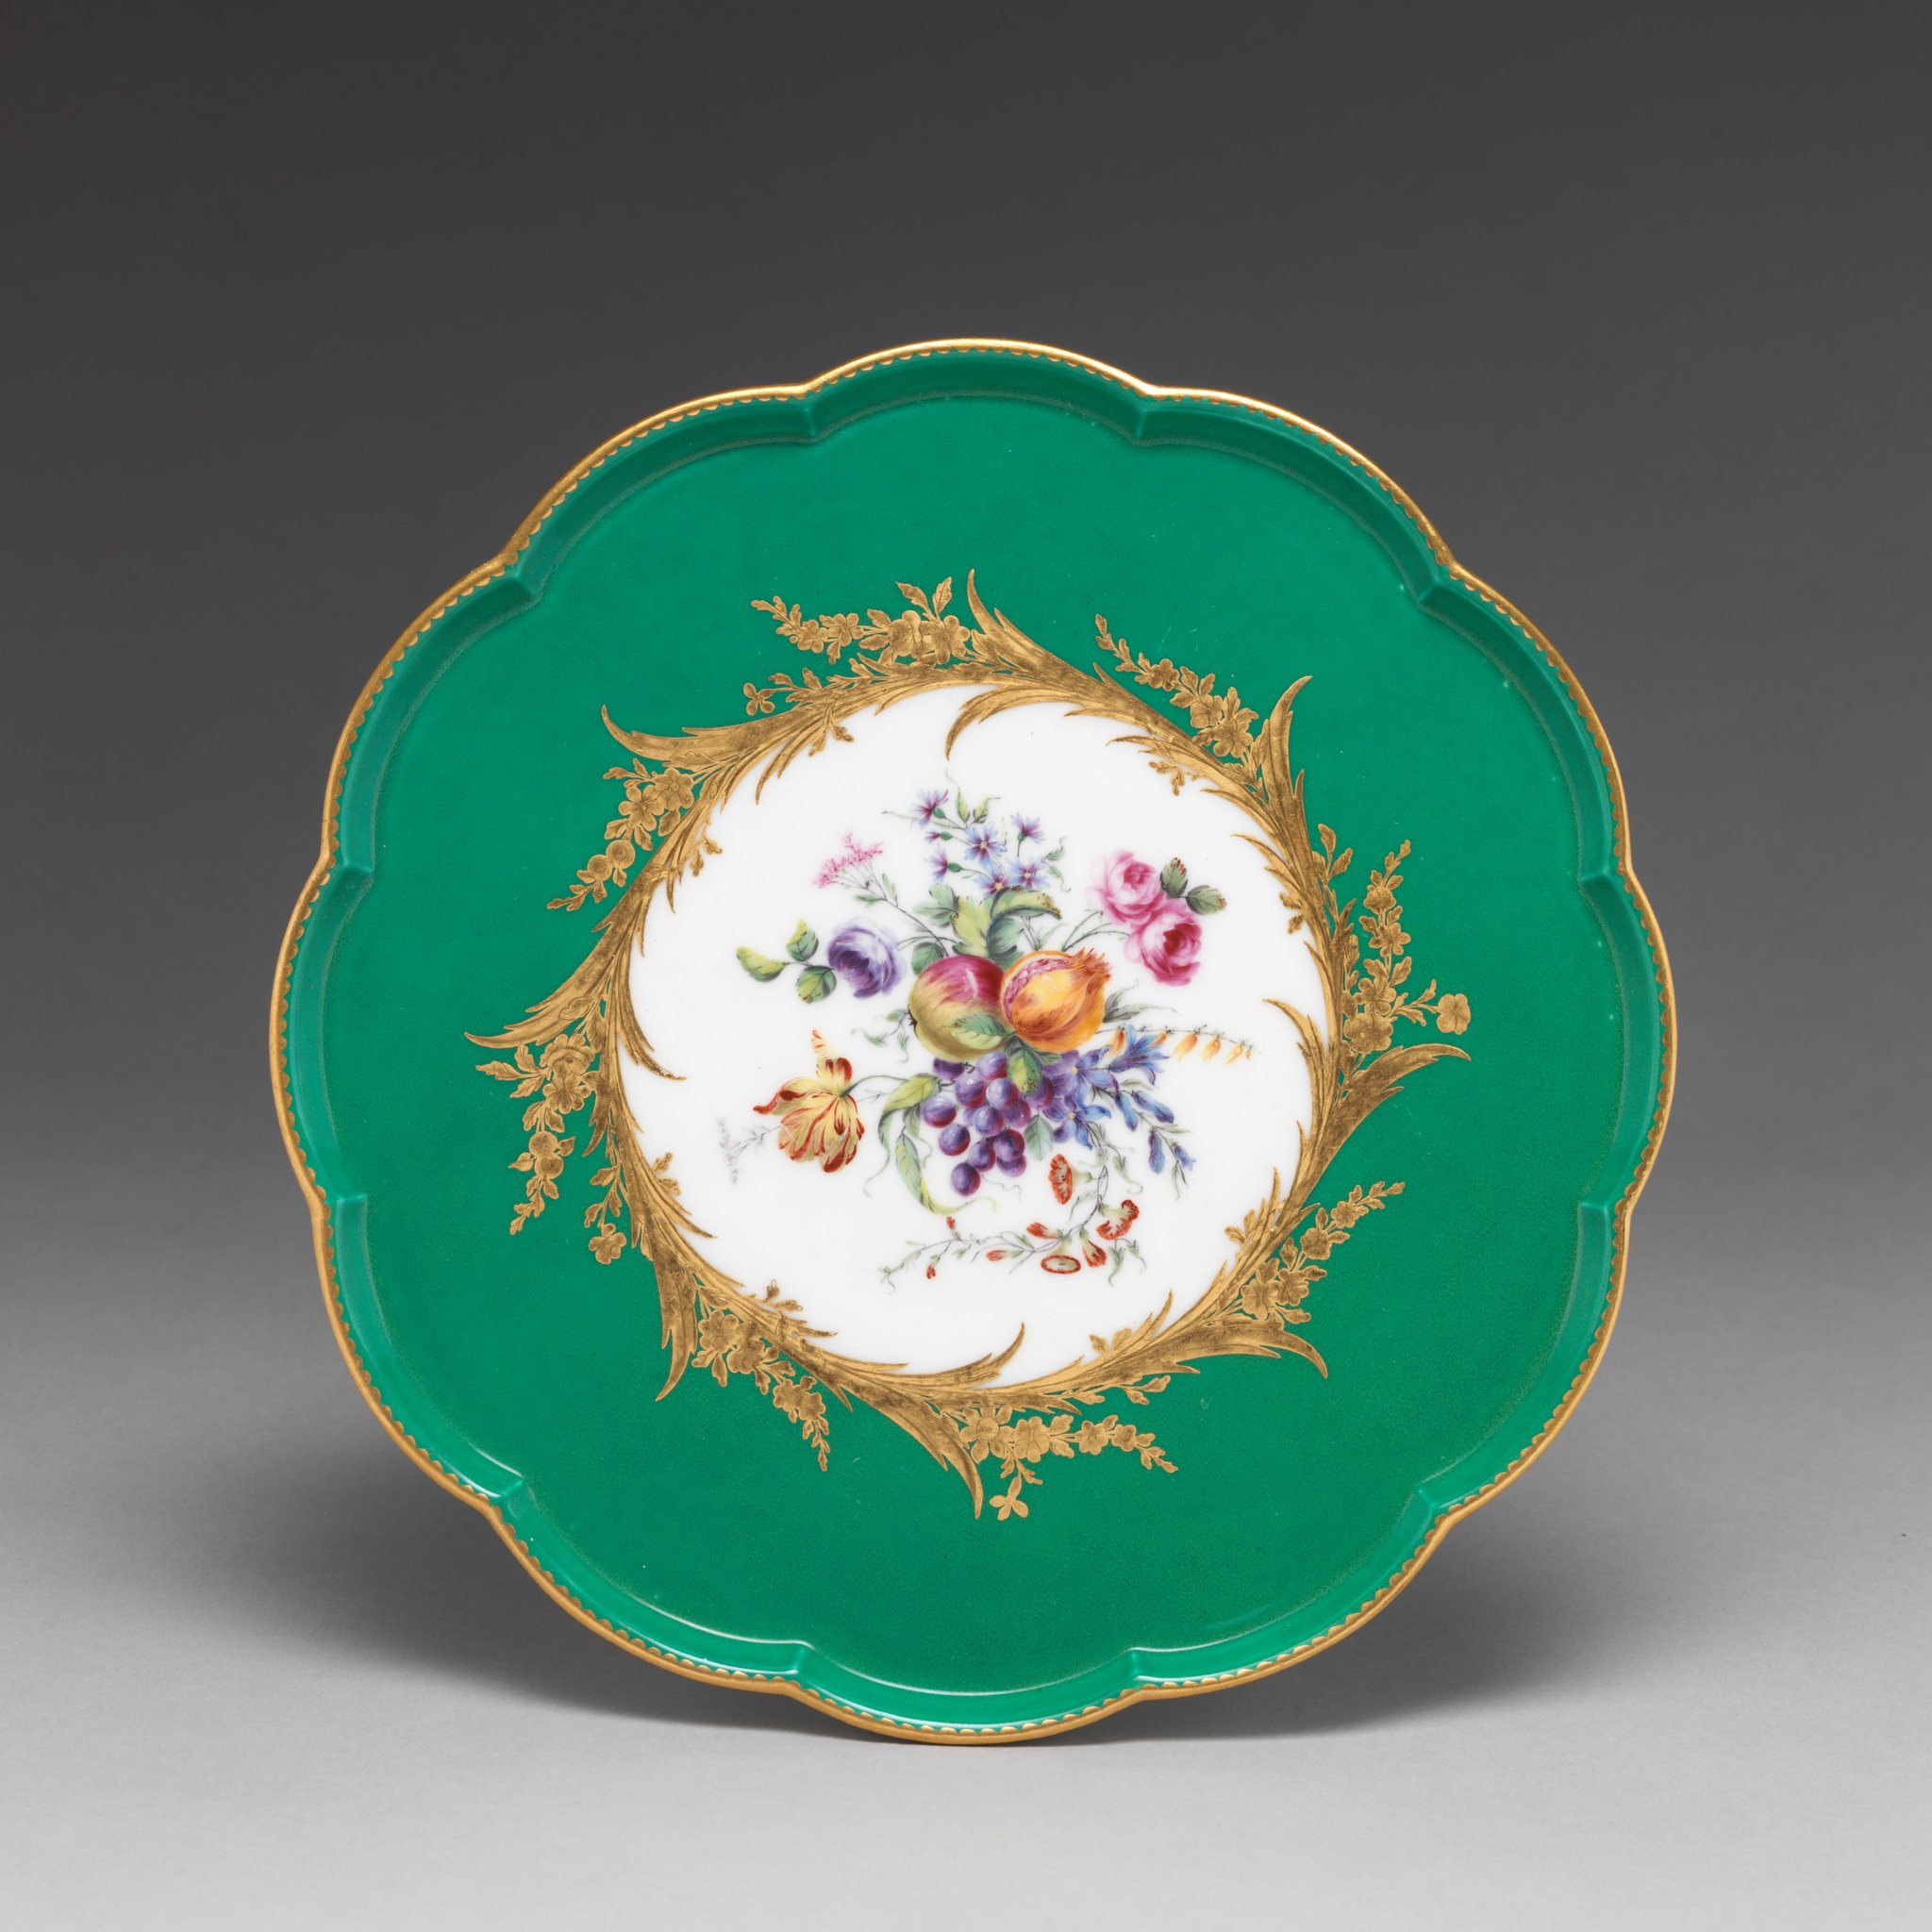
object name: tray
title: Tray (part of a service)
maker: sèvres manufactory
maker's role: manufactory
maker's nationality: french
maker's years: 1740-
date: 1772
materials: hard paste porcelain